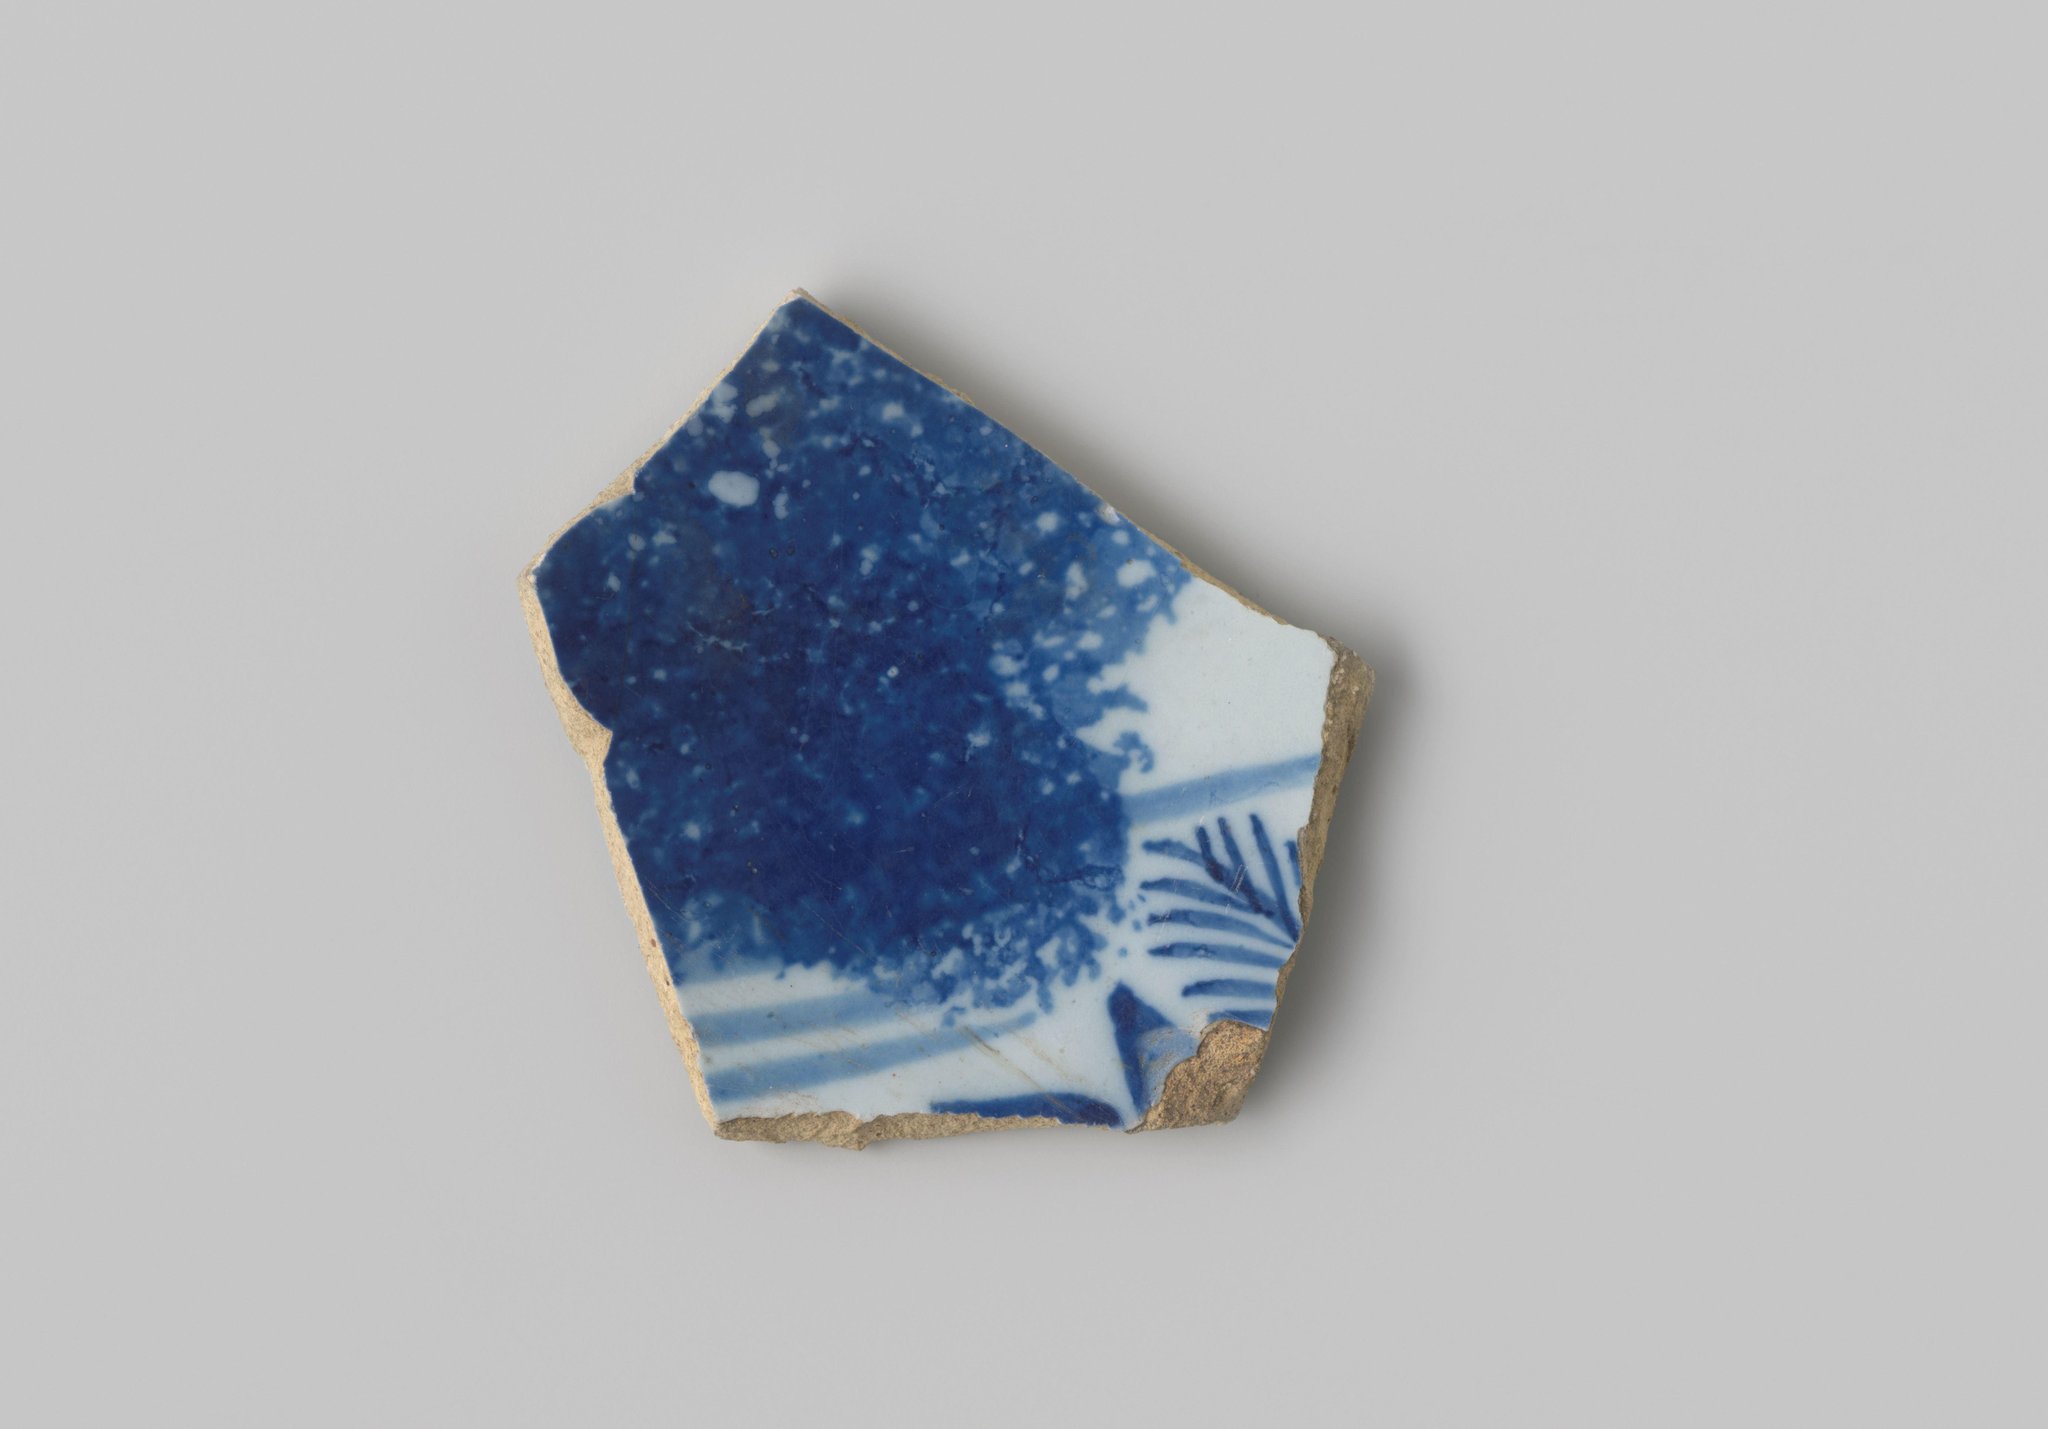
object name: sherd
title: Scherf van witbakkend aardewerk, aan de buitenzijde voorzien van een beschildering in blauw op een witte ondergrond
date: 1500-1899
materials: earthenware, glaze